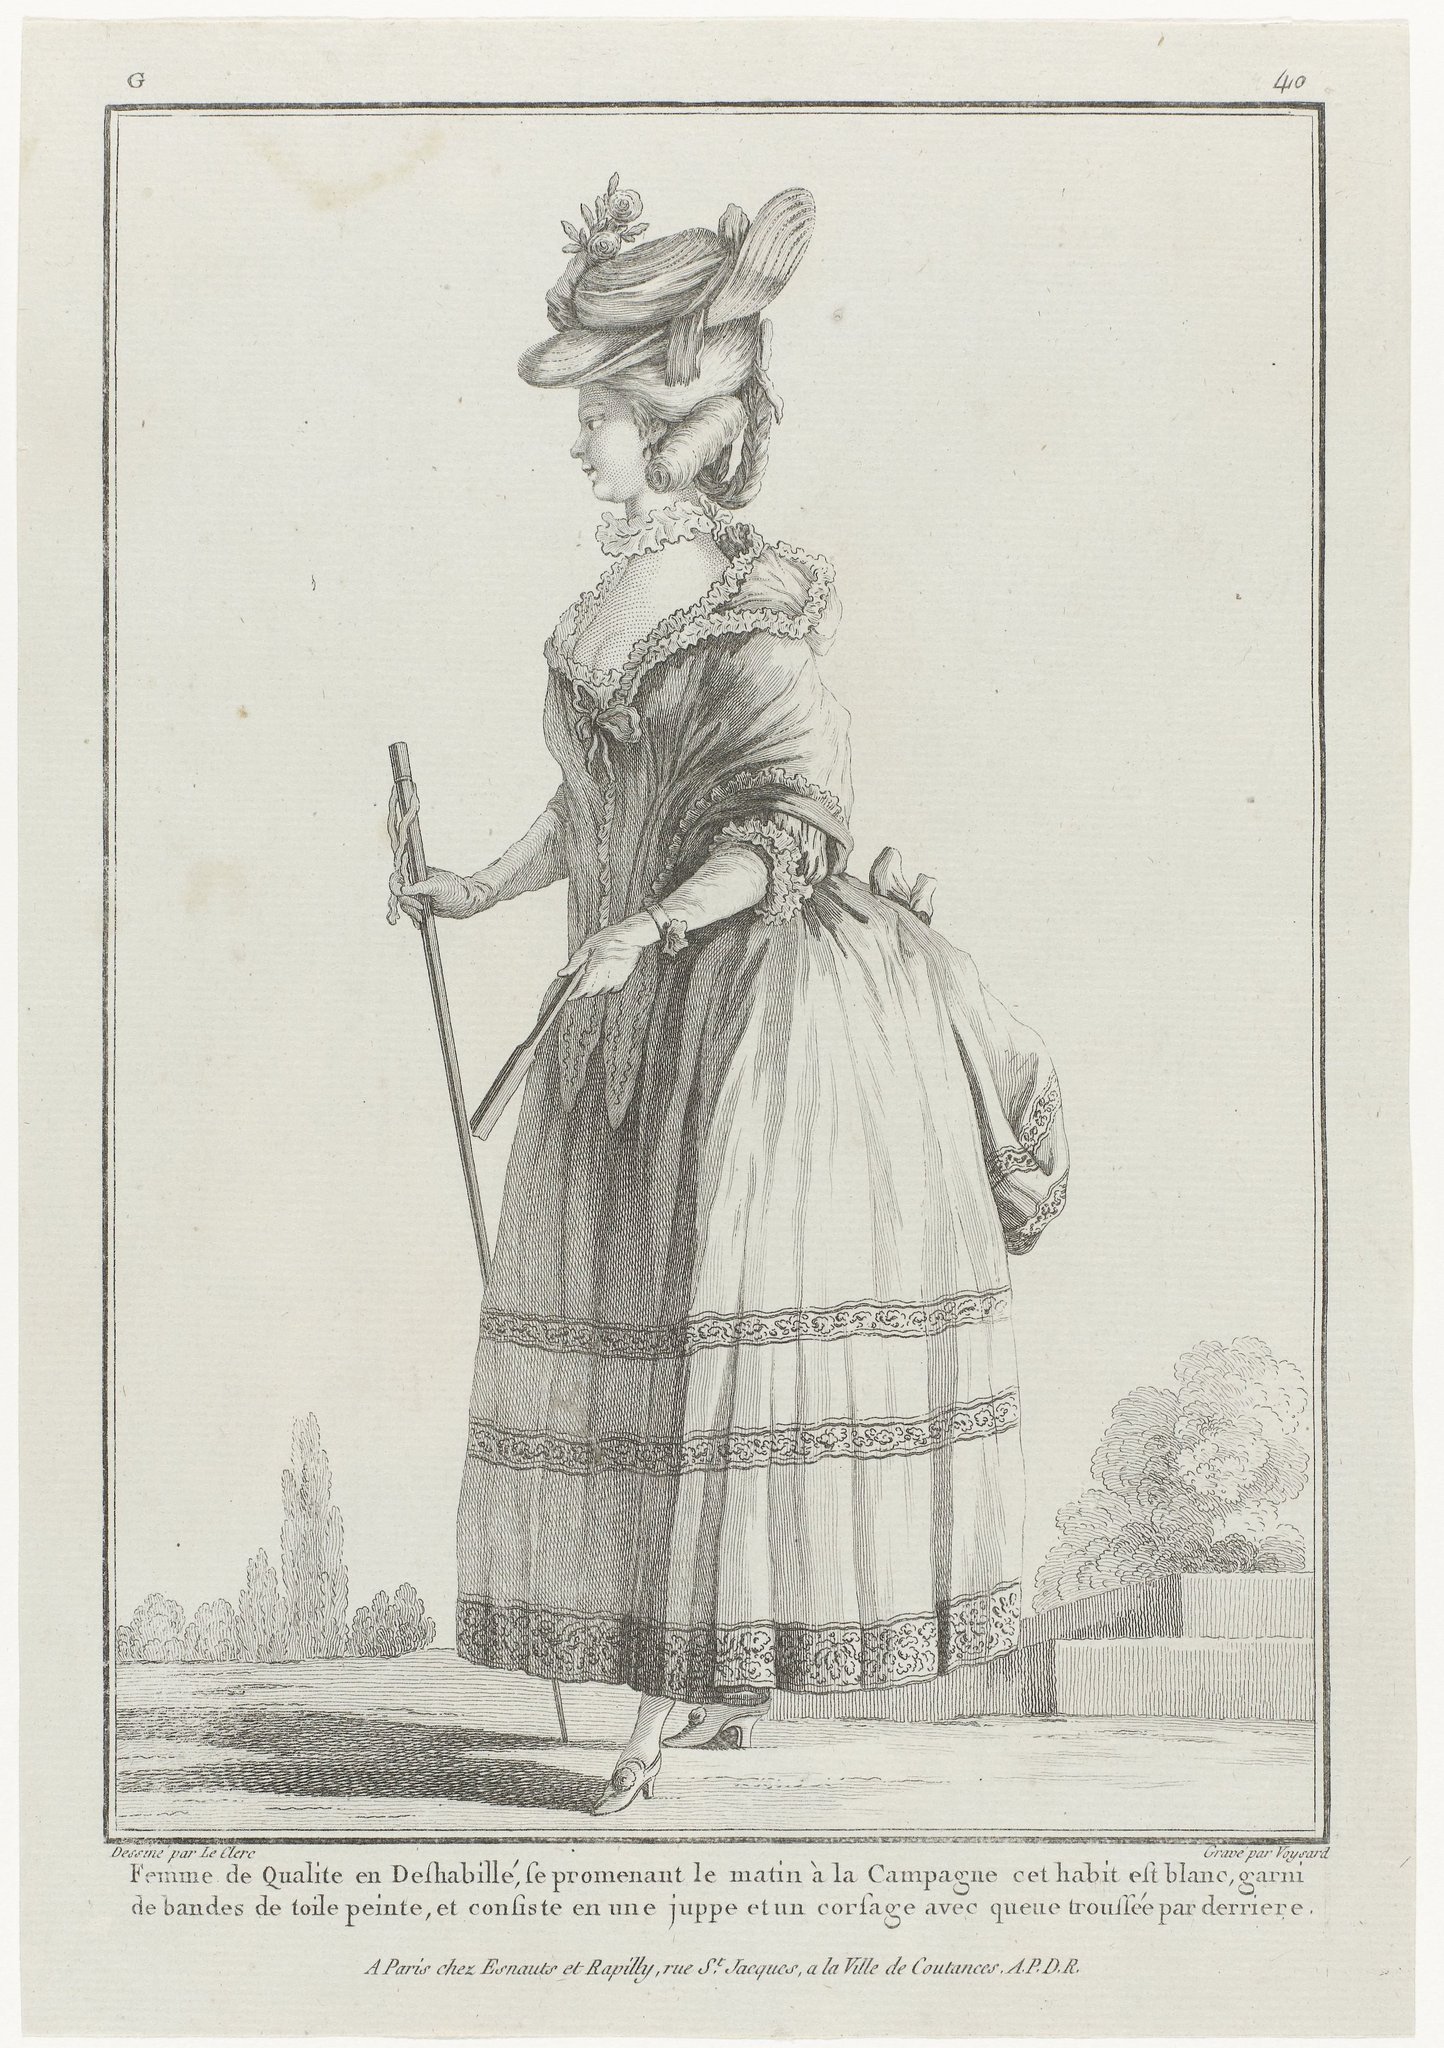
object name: fashion print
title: Gallerie des Modes et Costumes Francais, 1778, G 40 : Femme de Qualité en Deshabillé (...)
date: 1778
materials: paper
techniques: engraving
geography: paris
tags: clothing for the upper part of the body (+ women's clothes), walking-stick, staff, cane (+ women's clothes), dress, gown: morning dress (+ women's clothes), border, ribbon, braid (+ women's clothes), clothing for the upper part of the body (mantelet) (+ women's clothes), head-gear (straw hat) (+ women's clothes), fashion plates, neck-gear ~ clothing (with name) (+ women's clothes), skirt (+ women's clothes), fan (+ women's clothes), dress, gown: robe à la polonaise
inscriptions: caption: ‘Femme de Qualite en Deshabillé, se promenant le matin à la Campagne cet habit est blanc, garni de bandes de toile peinte, et consiste en une juppe et un corsage avec queue troussée par derriere.’, address: ‘A Paris chez Esnauts et Rapilly, rue St. Jacques, a la Ville de Coutances. A.P.D.R.’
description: Vrouw van stand, op het platteland wandelend in een witte ochtendjapon of 'deshabillé'. De 'demi-polonaise' bestaat uit een een lijfje en een schoudermanteltje met capuchon en een rok met kleine queu. Strohoed met linten en bloemen om het gezicht tegen de zon te beschermen. Schoenen met hakken en rozetten. Verdere accessoires: collerette, lange handschoenen, armband, waaier, wandelstok. Prent uit serie G. 7e Cahier des Costumes Français, 1re Suite d'Habillemens de Femmes à la mode, Gallerie des Modes et Costumes Français.